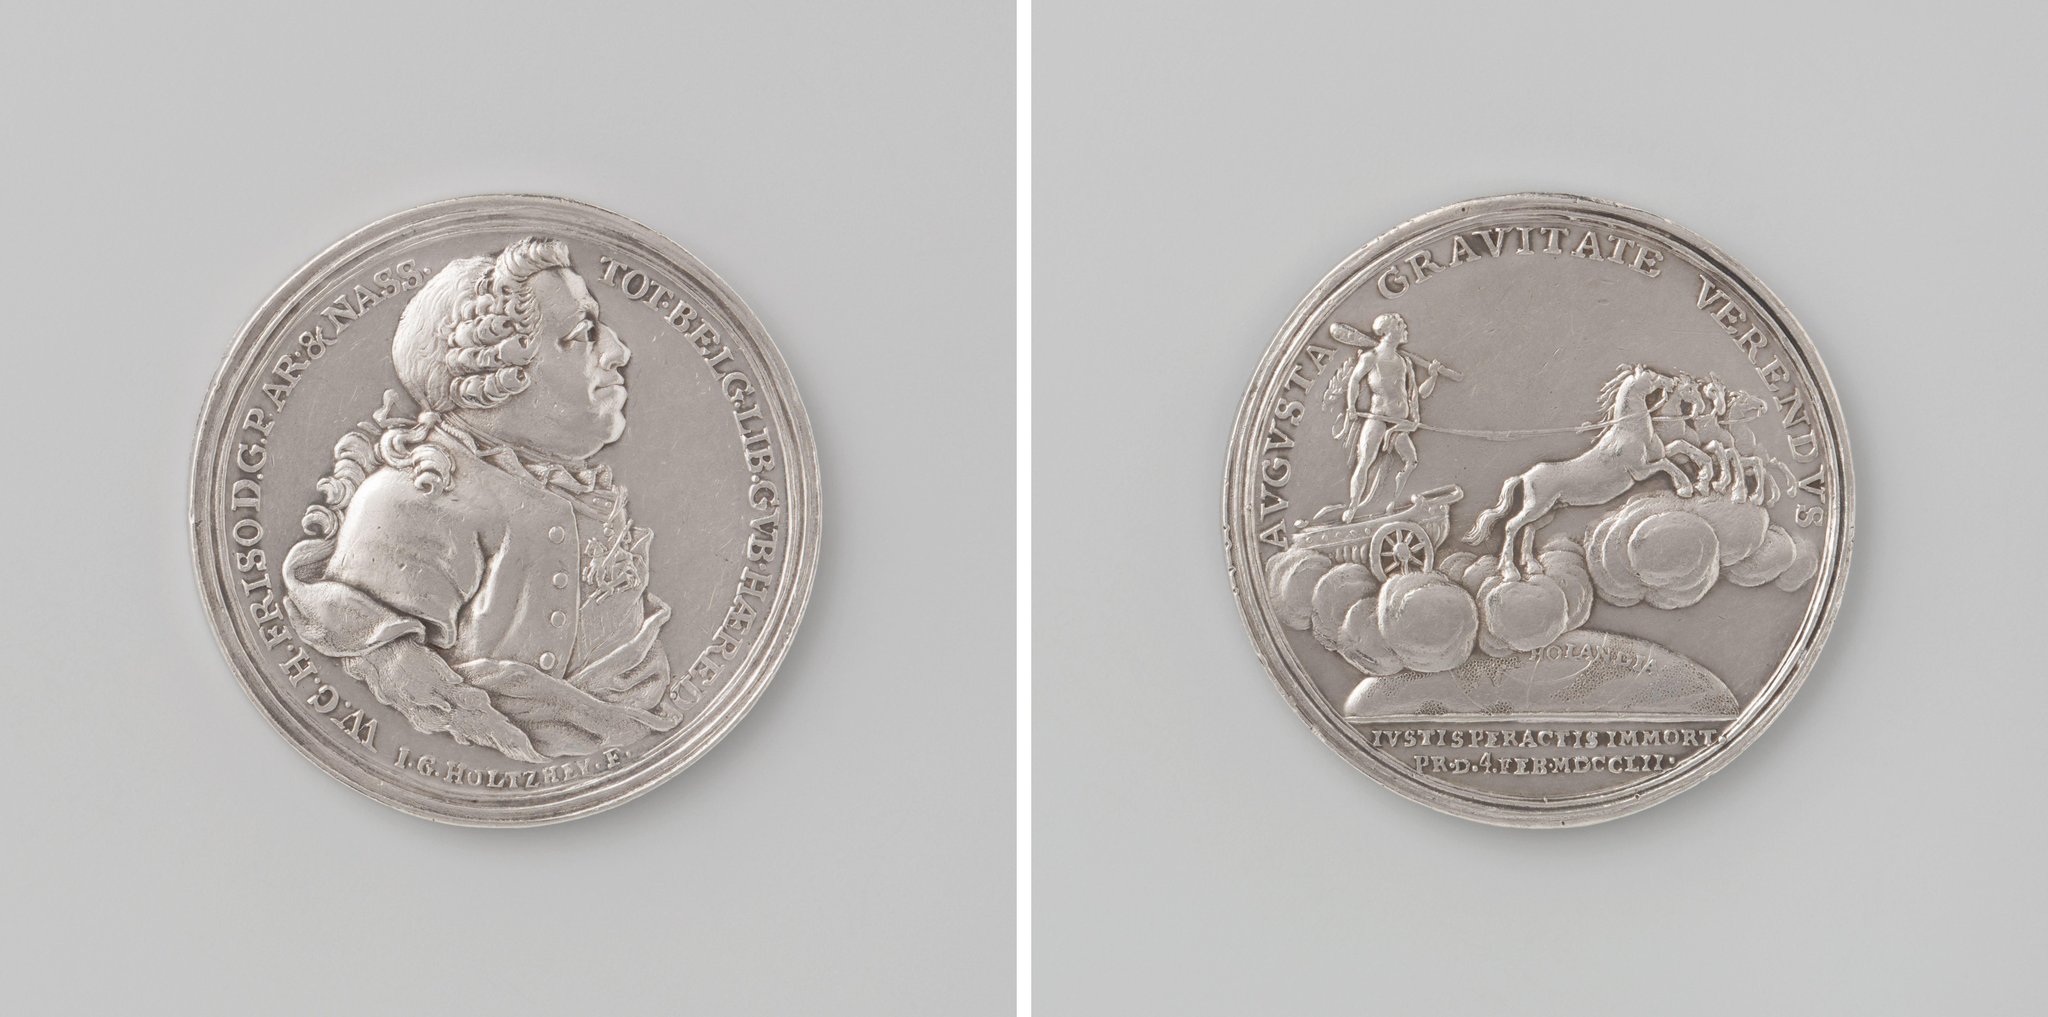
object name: history medal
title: Begrafenis van Willem IV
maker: johan george holtzhey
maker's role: mintmaster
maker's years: 1726-1808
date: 1752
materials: silver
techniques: striking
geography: amsterdam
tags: the hague, willem iv (prins van oranje-nassau)